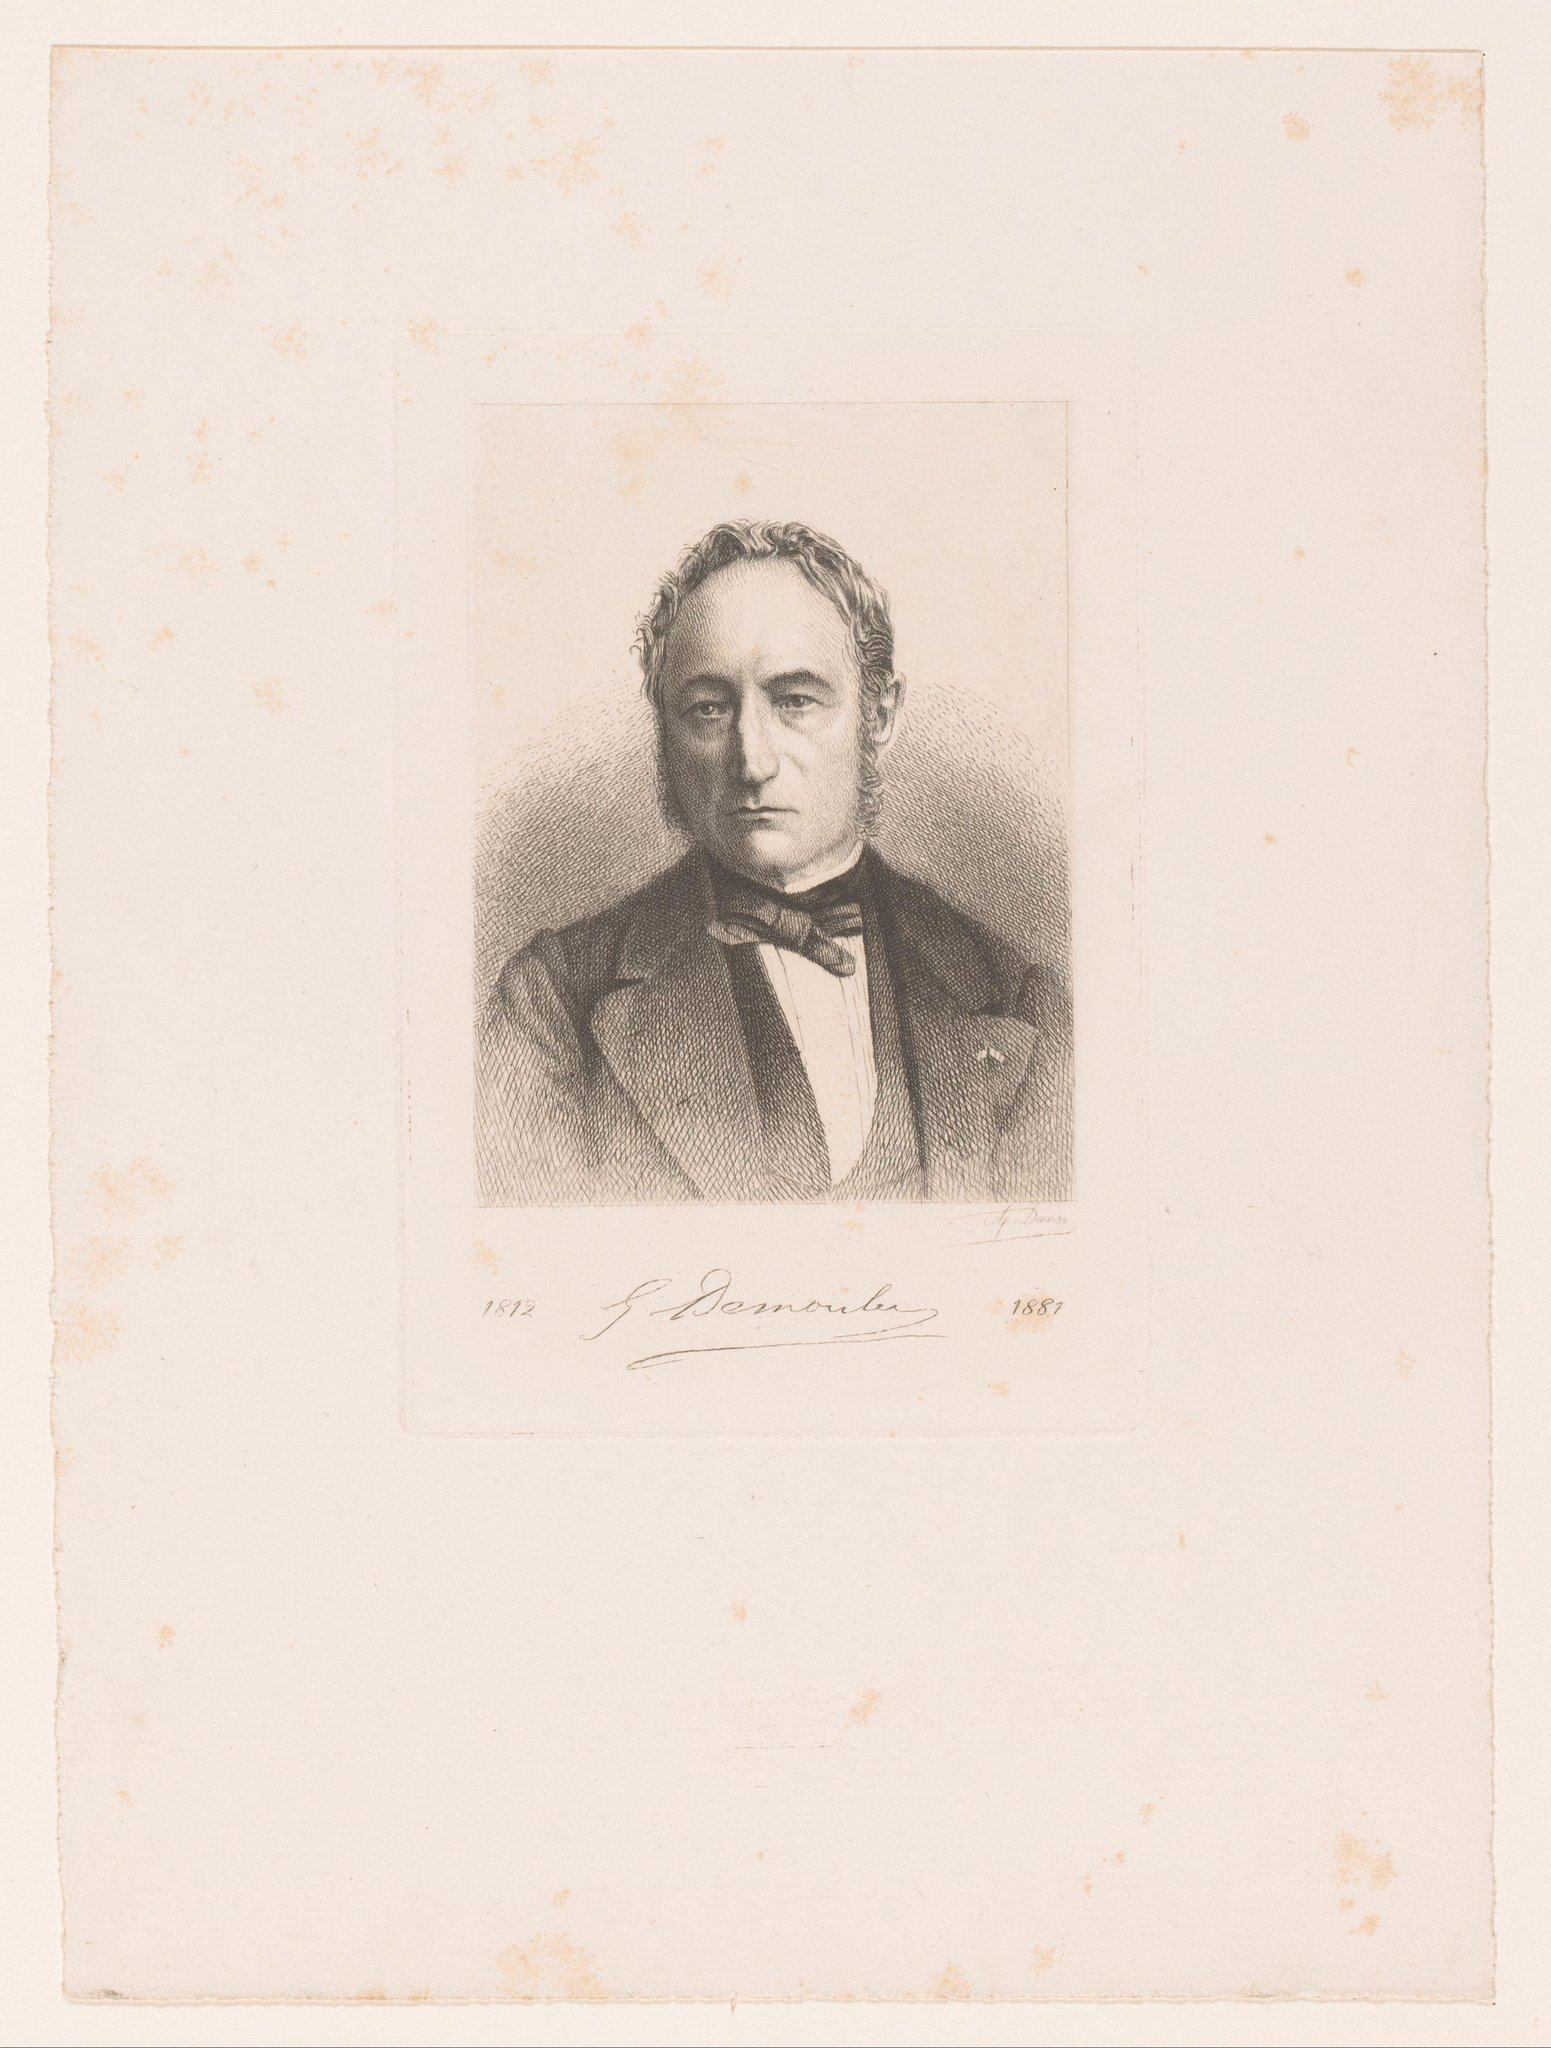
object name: print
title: Portret van G. Demoulin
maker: auguste danse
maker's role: print maker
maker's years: 1829-1929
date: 1882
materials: paper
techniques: etching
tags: historical person (...) - historical person (...) portrayed alone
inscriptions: collector's mark: Lugt 2228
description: Mogelijk is de afgebeelde persoon de G. Demoulin die van 1865 voorzitter was van de Société royale d'Horticulture de Mons.